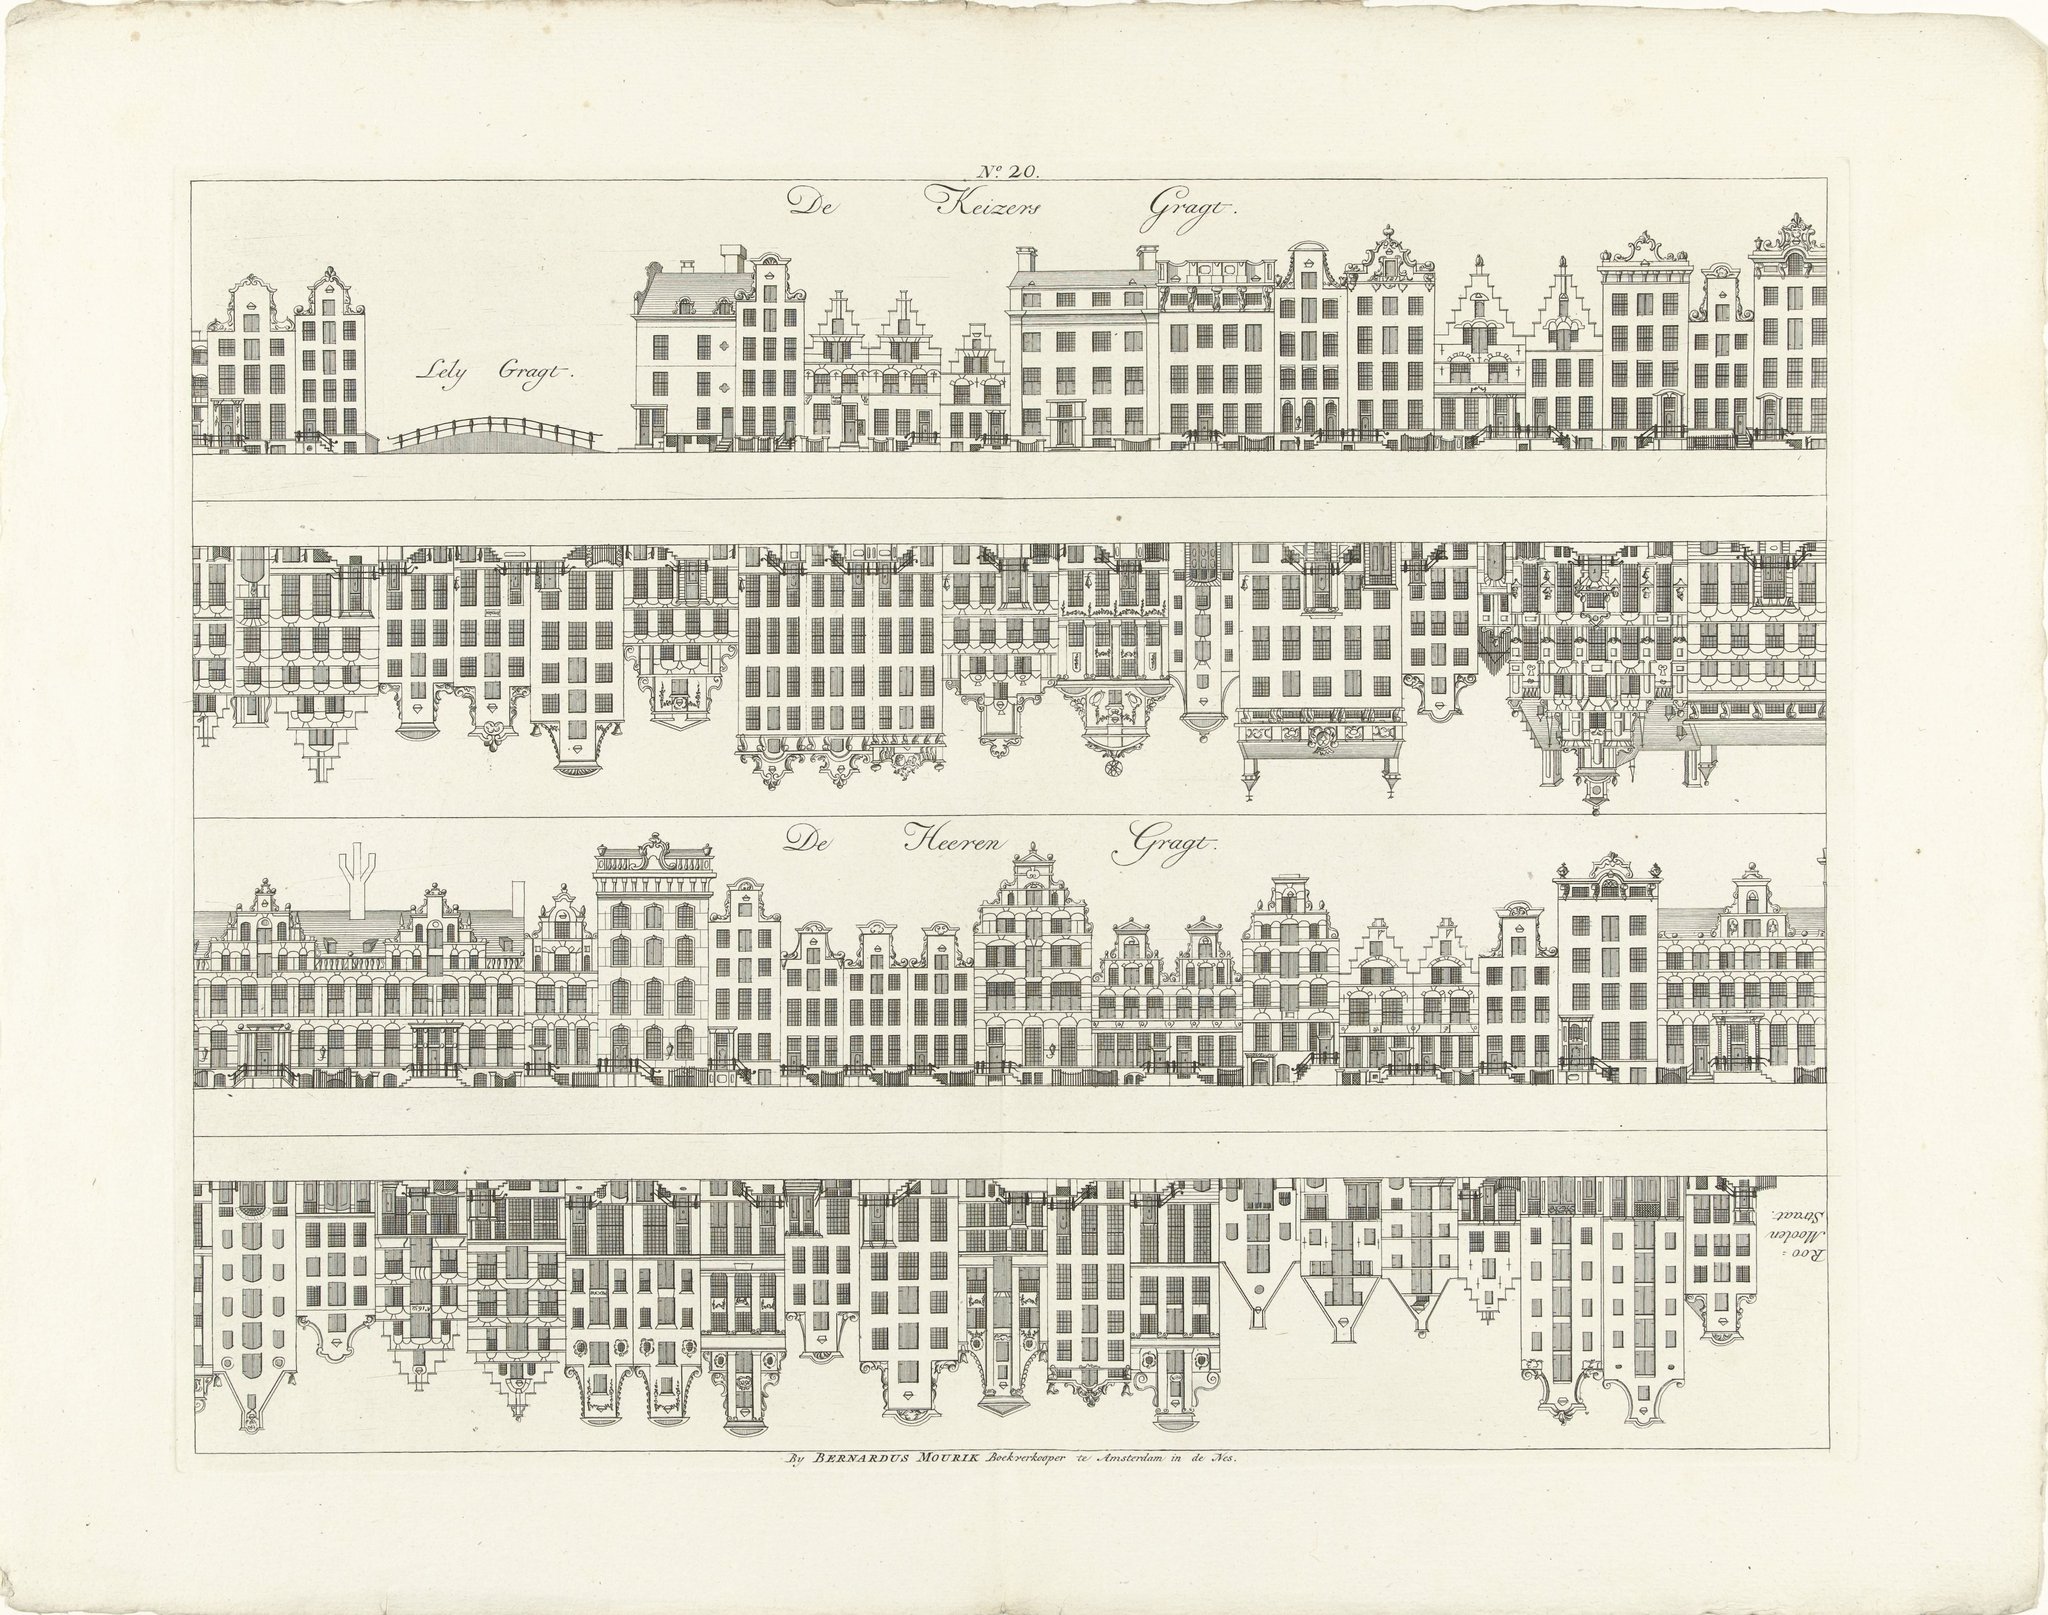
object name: print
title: Gevels van huizenrijen aan de Keizersgracht naar de Leliegracht en de Herengracht naar de Roomolenstraat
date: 1768-1771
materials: paper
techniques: etching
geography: amsterdam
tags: front façade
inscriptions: collector's mark: Lugt 2233, collector's mark: Lugt 2228